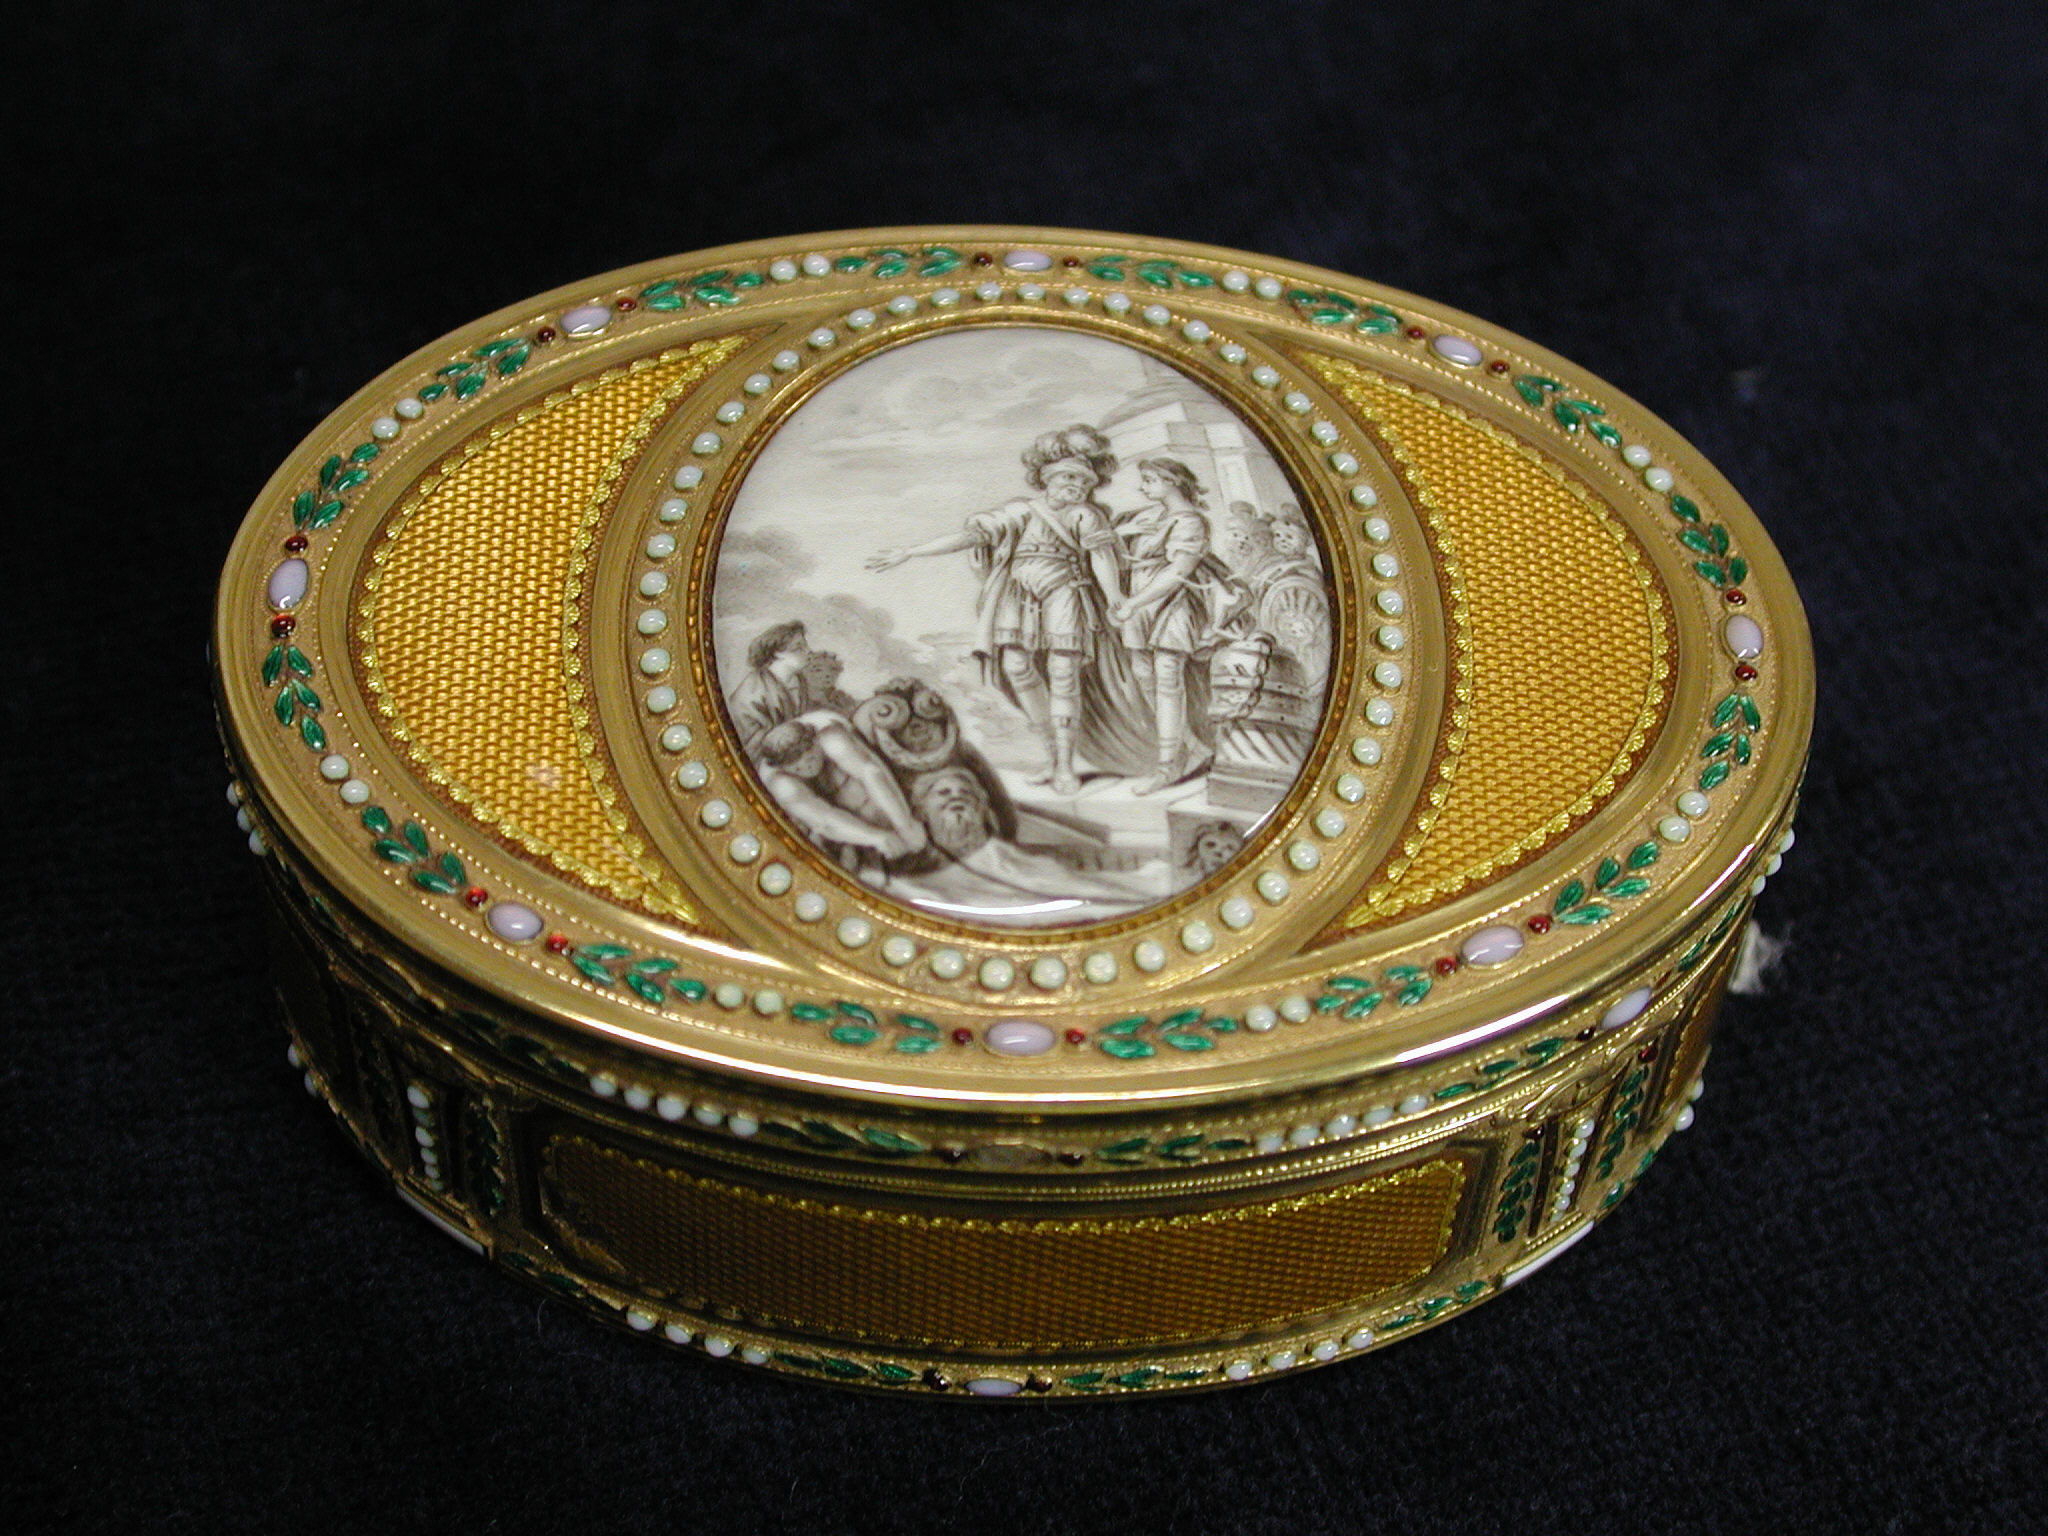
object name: snuffbox, painting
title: Snuffbox with miniature depicting departure of Telemachus from Egypt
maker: charles ouizille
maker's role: maker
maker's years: 1745-1845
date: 1780-1781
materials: enamel, gold